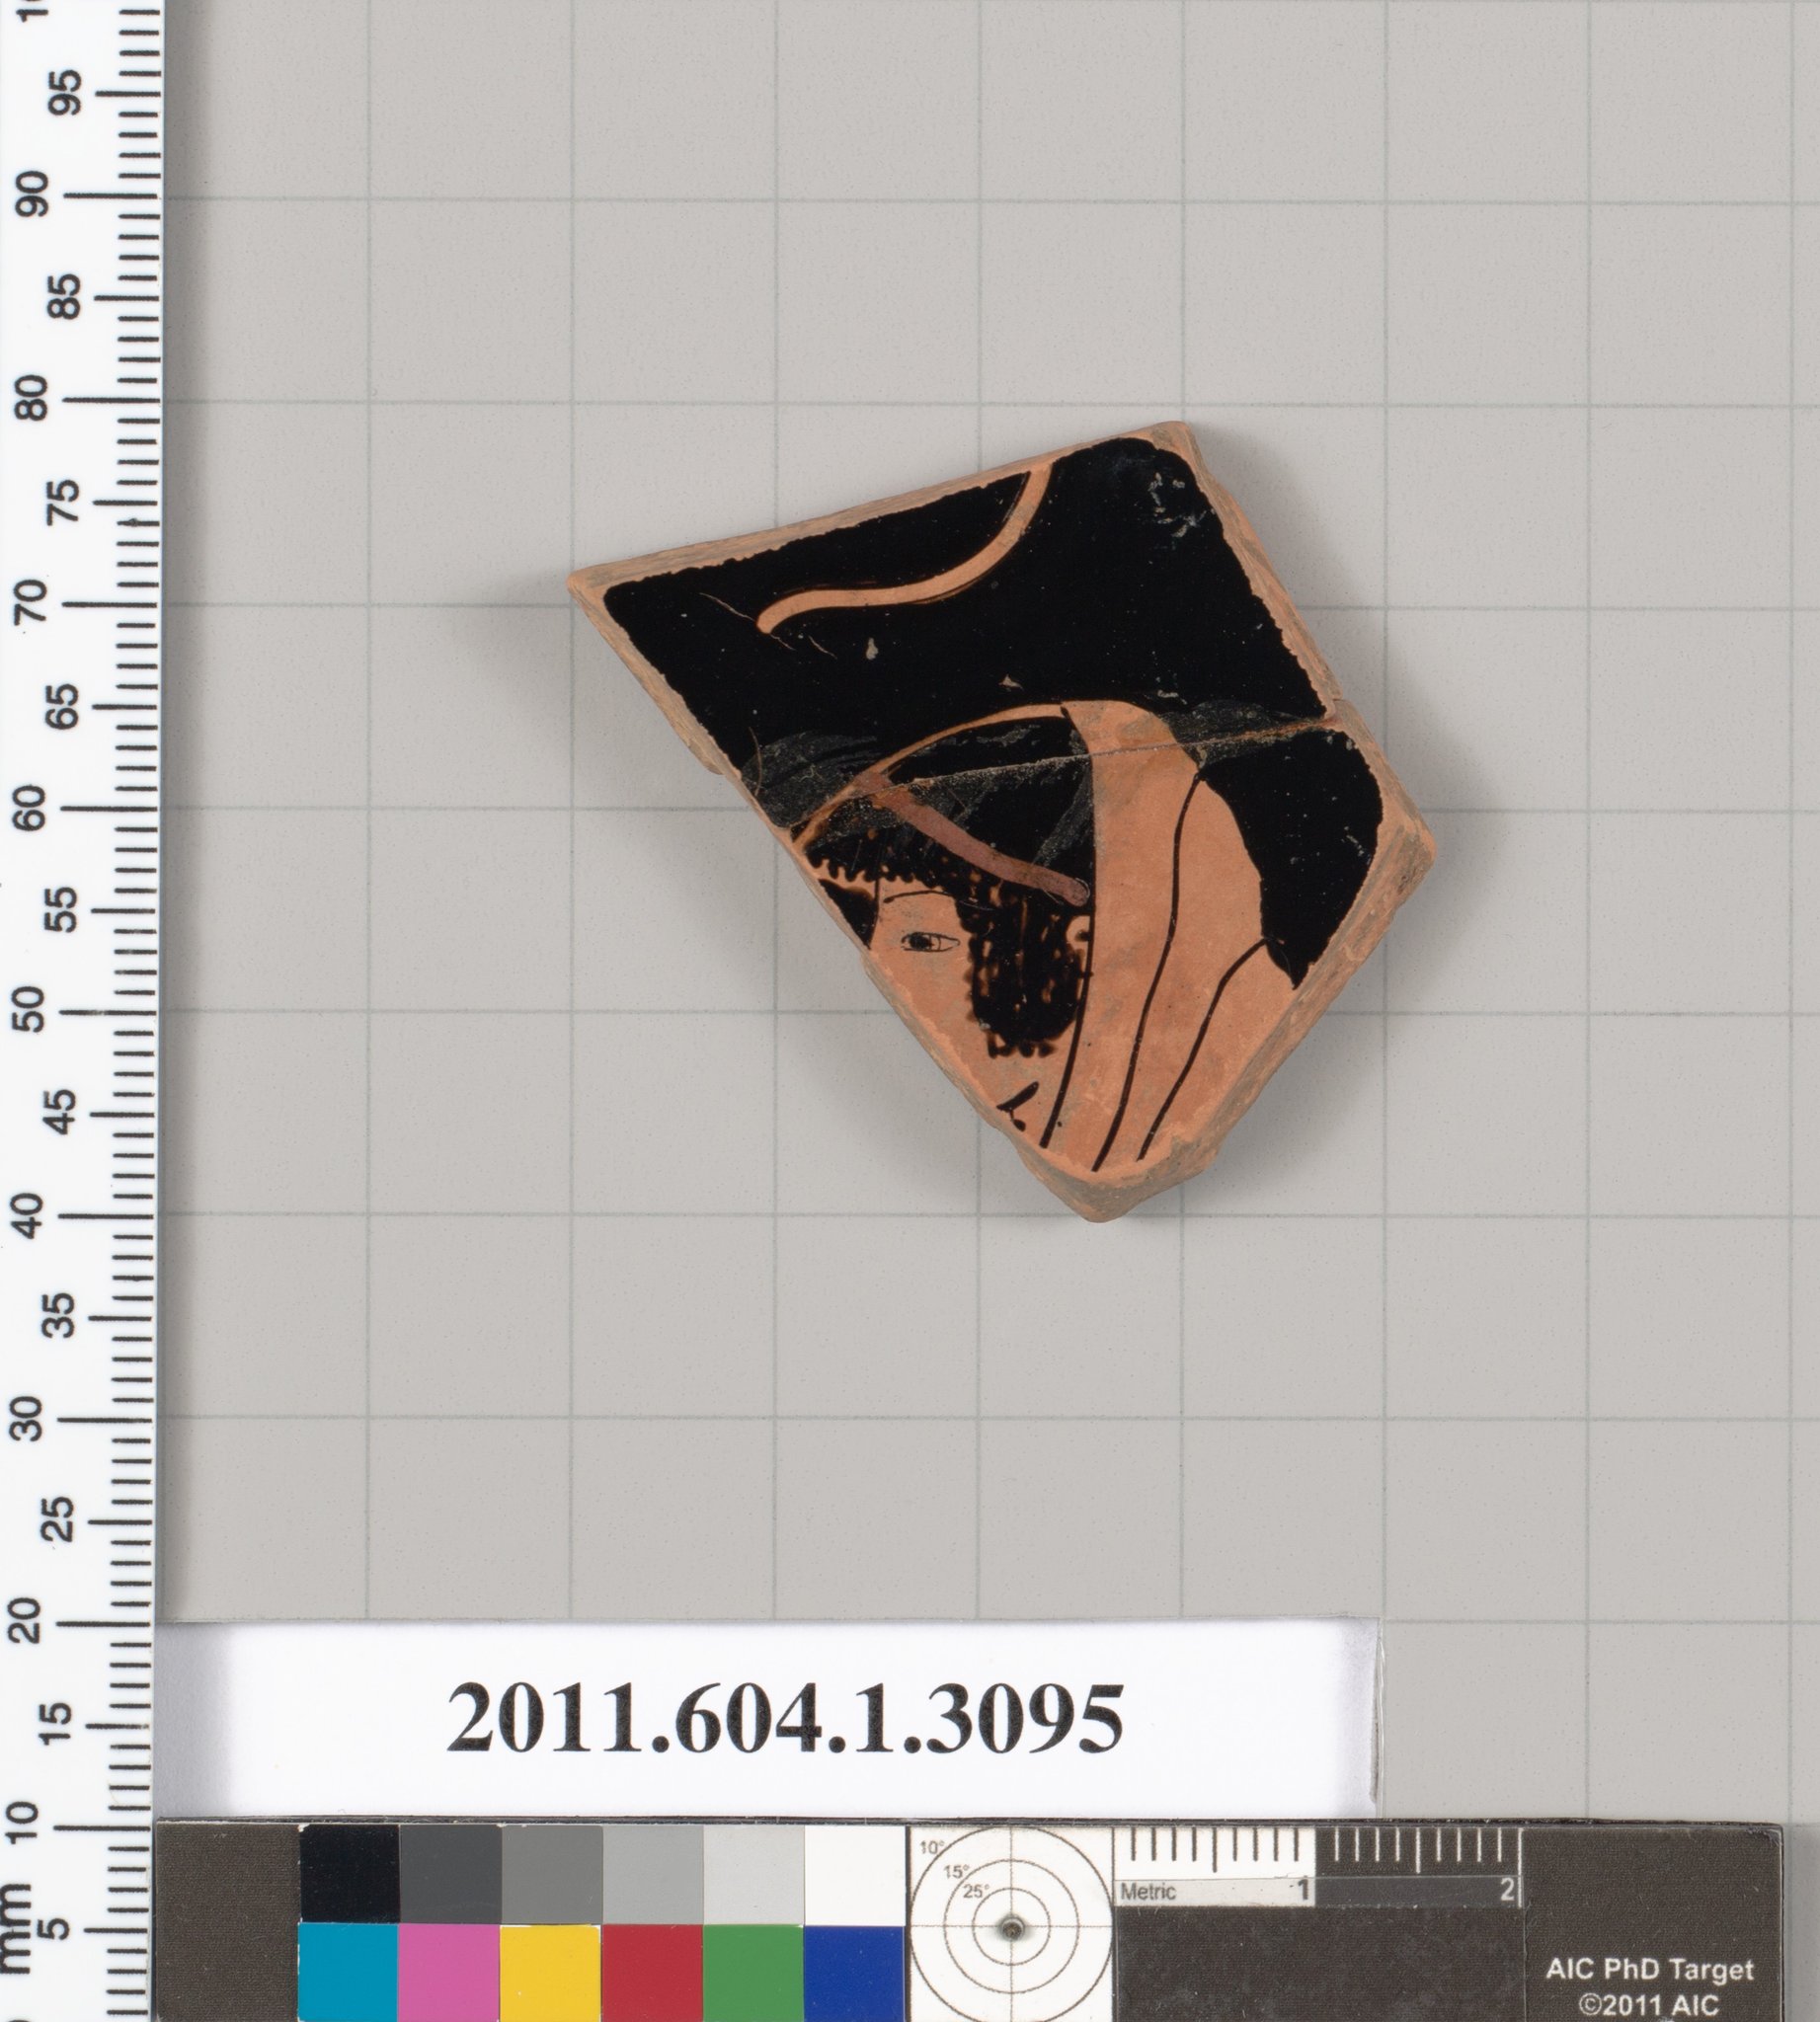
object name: kylix fragment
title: Terracotta fragment of a kylix (drinking cup)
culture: greek, attic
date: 490-480 BCE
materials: terracotta